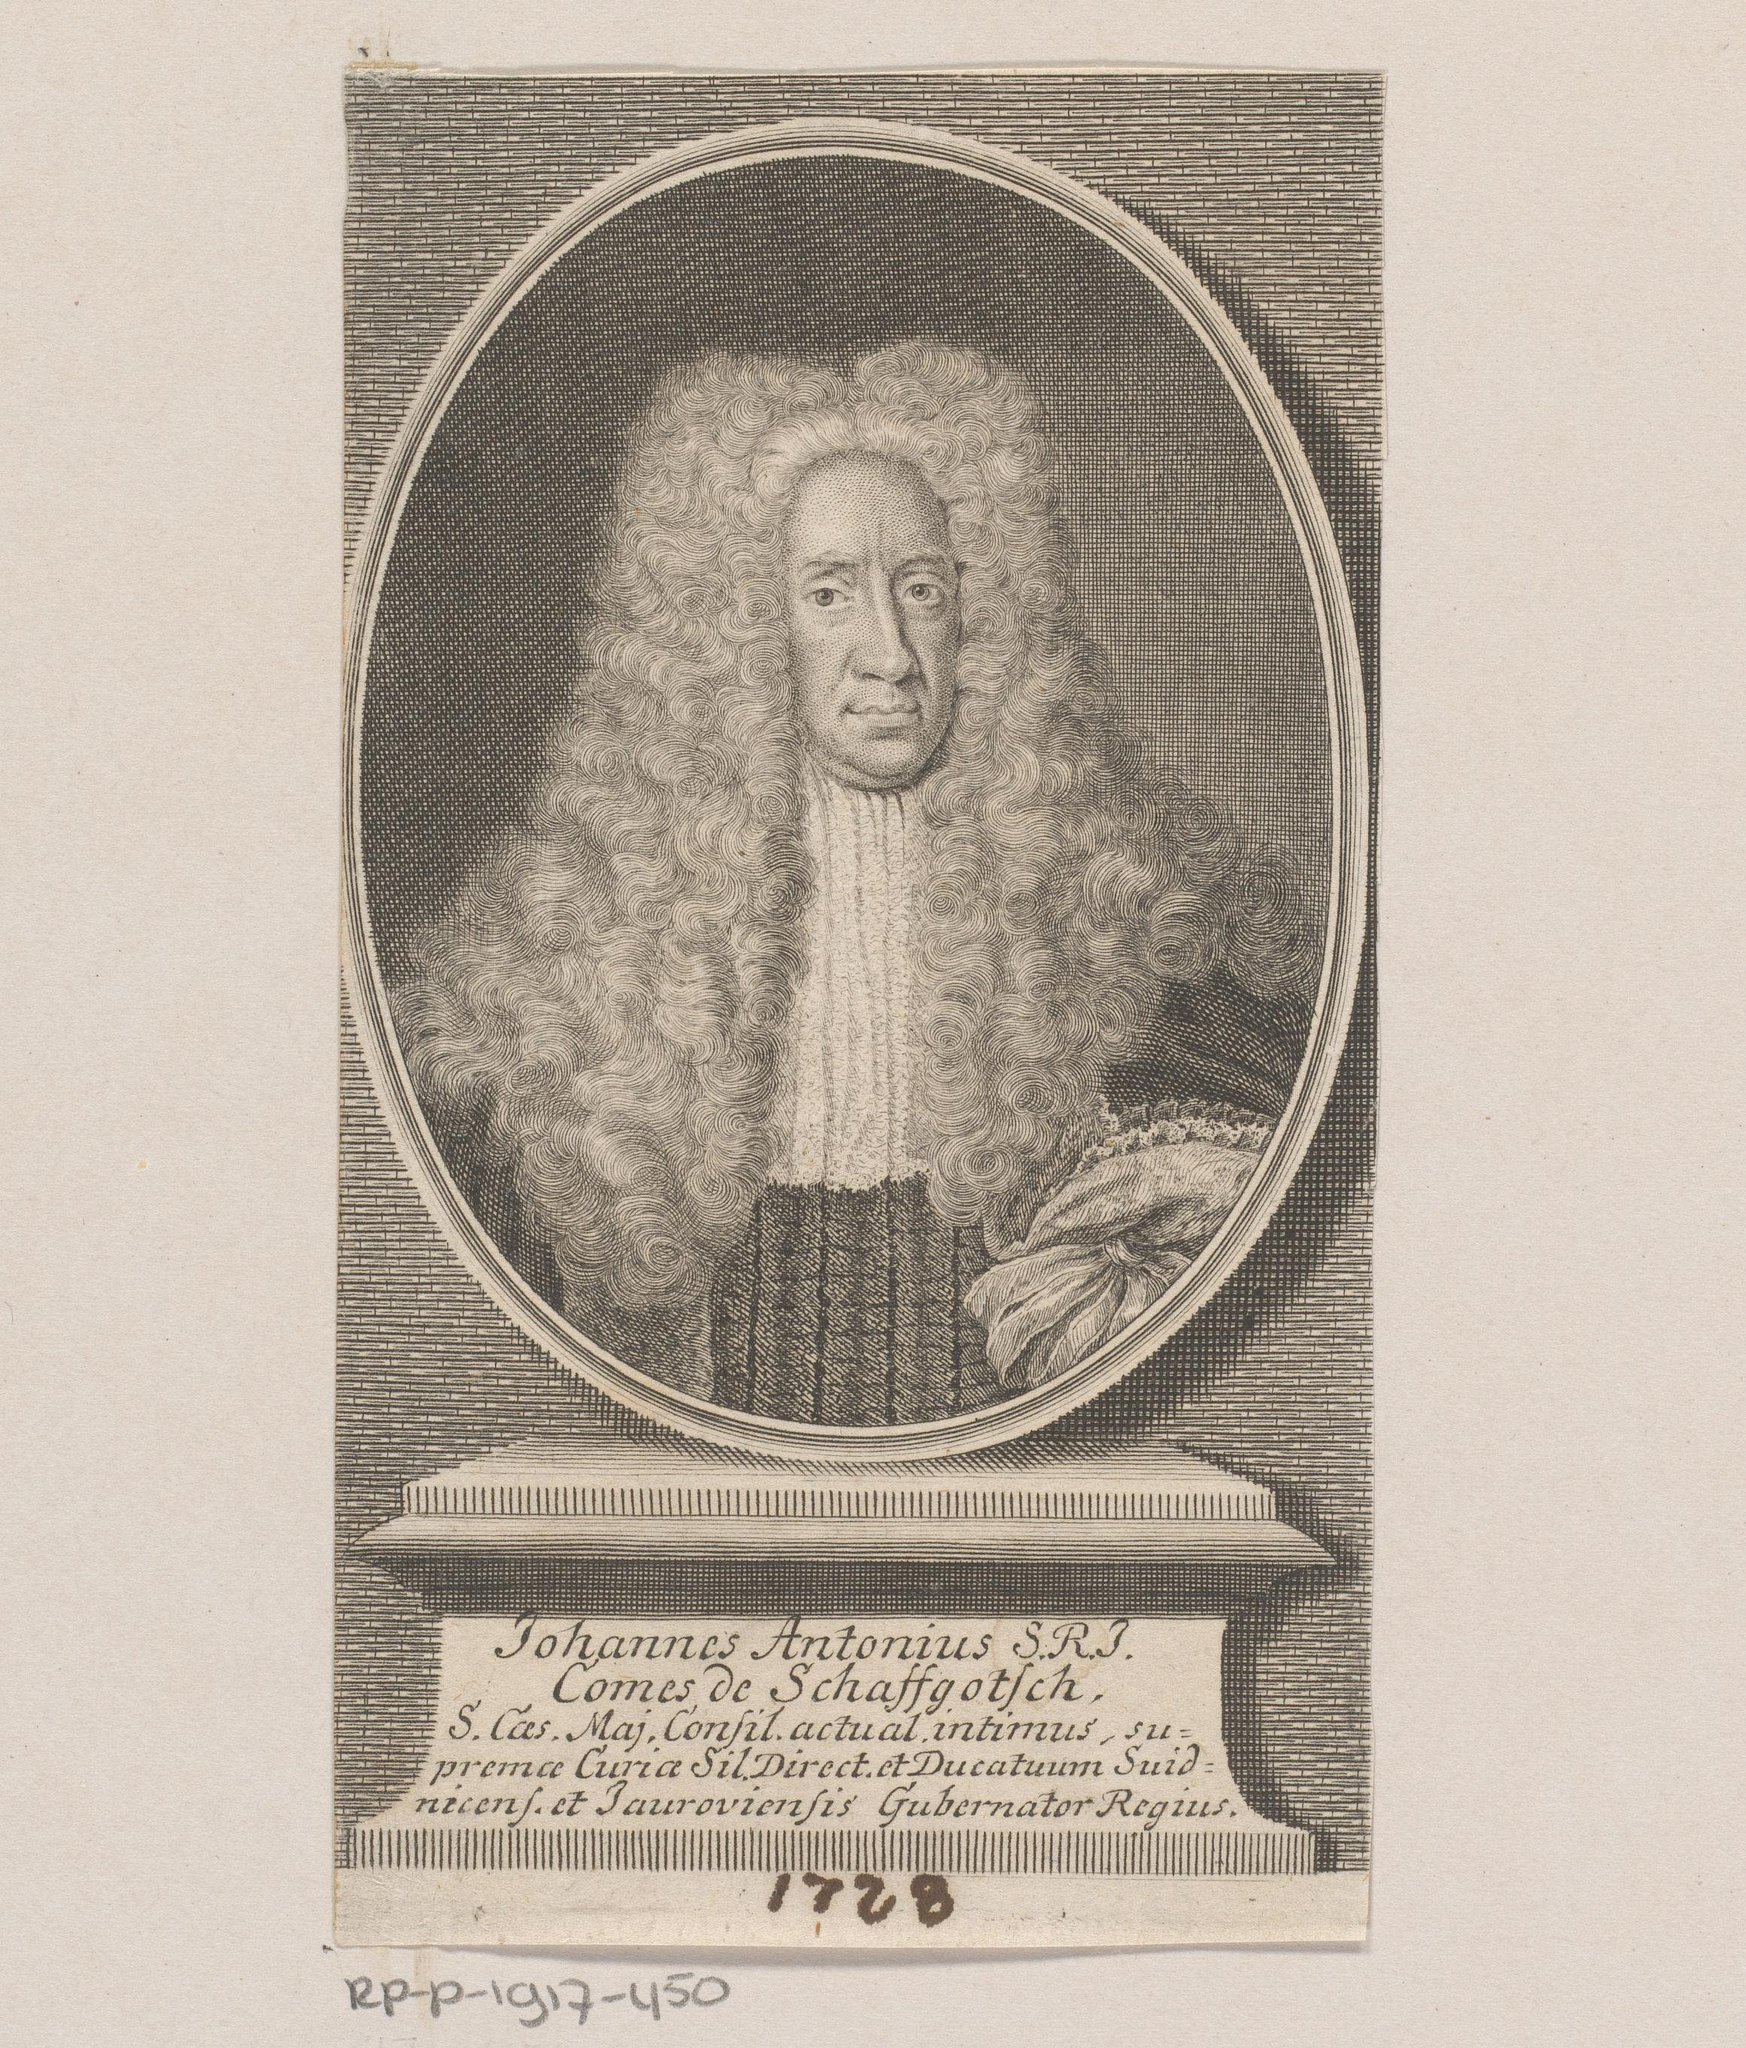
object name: print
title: Portret van Johann Anton von Schaffgotsch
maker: martin bernigeroth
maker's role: print maker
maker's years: 1670-1733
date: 1729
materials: paper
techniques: engraving, etching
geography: leipzig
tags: historical persons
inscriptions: number: ‘1728’, collector's mark: Lugt 2228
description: Prent waarschijnlijk uit: Die Europäische Fama, Welche den gegenwärtigen Zustand der vornehmsten Höfe entdecket. Leipzig: Johann Friedrich Gleditsch, 1729, dl. 320.